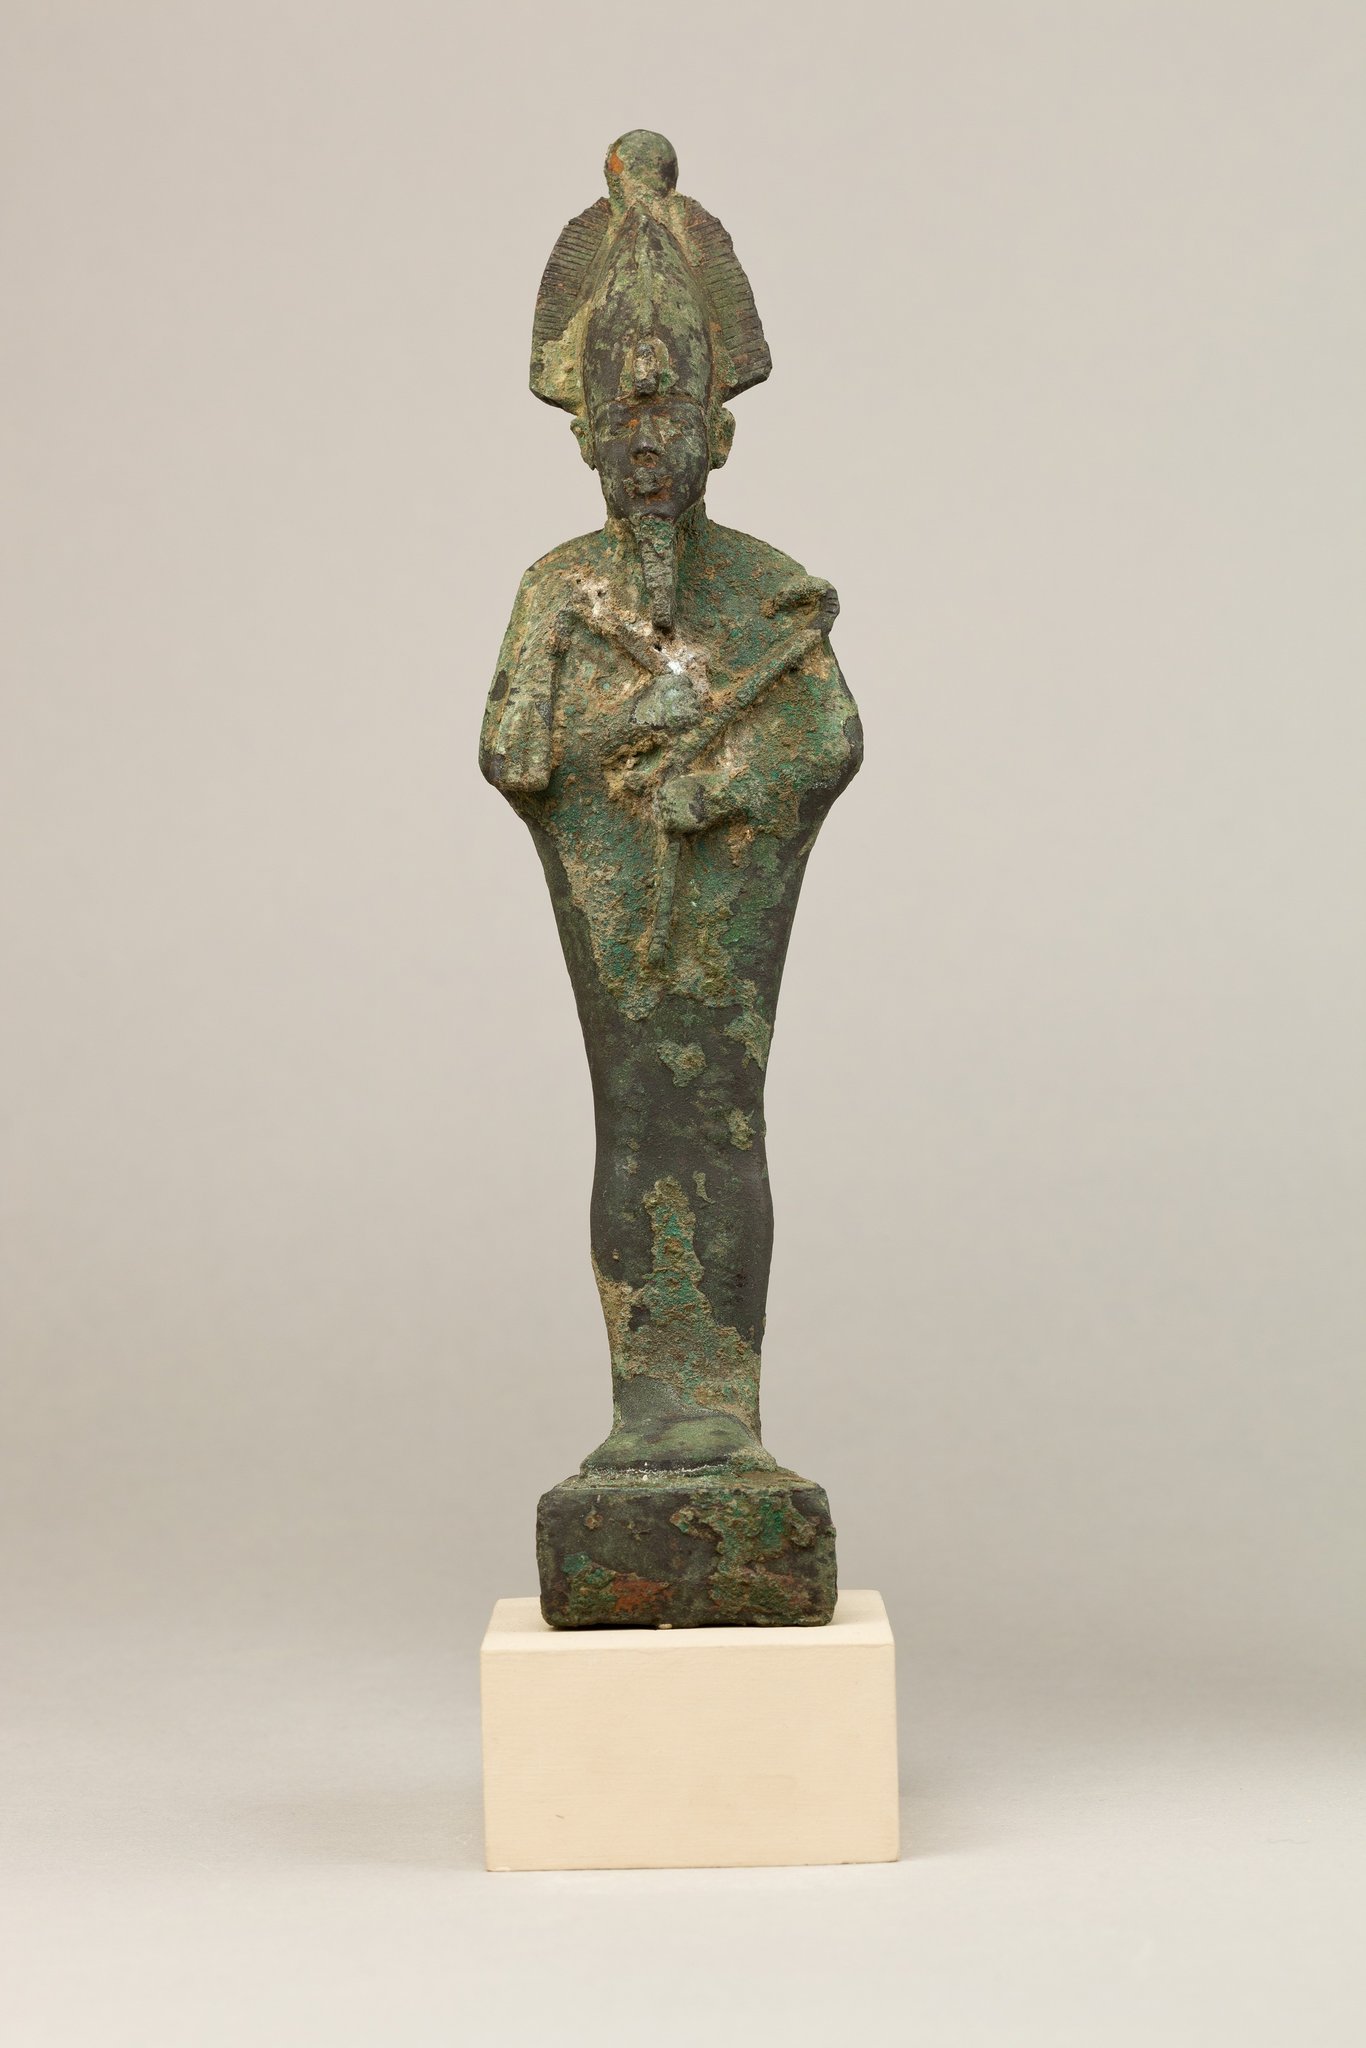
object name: statuette, osiris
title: Osiris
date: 664-630 BCE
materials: metal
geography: egypt